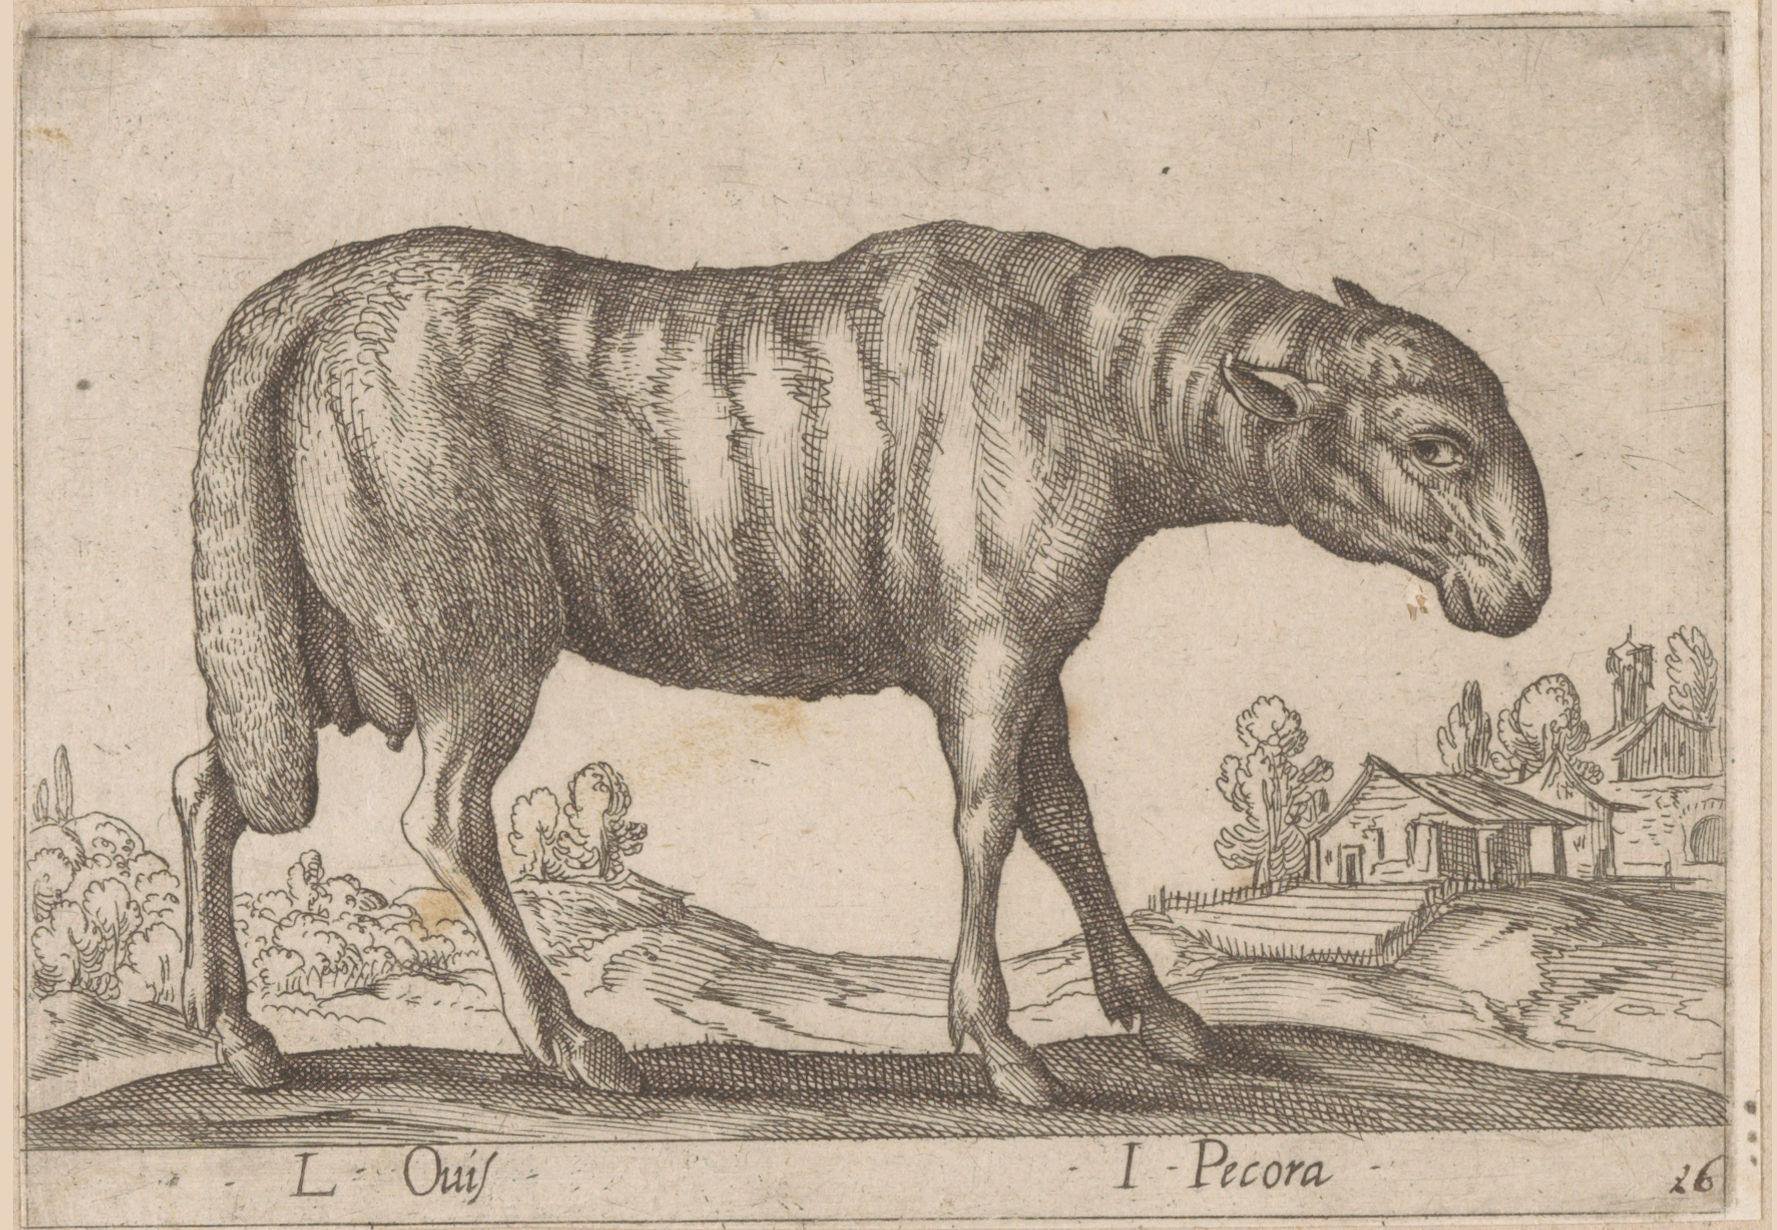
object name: print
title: Dieren en fabelwezens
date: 1565-1630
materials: paper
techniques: etching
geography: vatican city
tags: sheep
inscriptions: number: ‘26’, collector's mark: Lugt 11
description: Deze prent maakt deel uit van een reeks prenten van dieren door Antonio Tempesta. Bekend is dat een tweede staat (met nummering) van deze serie is uitgegeven door Giovanni Giacomo de' Rossi in 1650. Onbekend is wie de eerste staat heeft uitgegeven en wanneer.